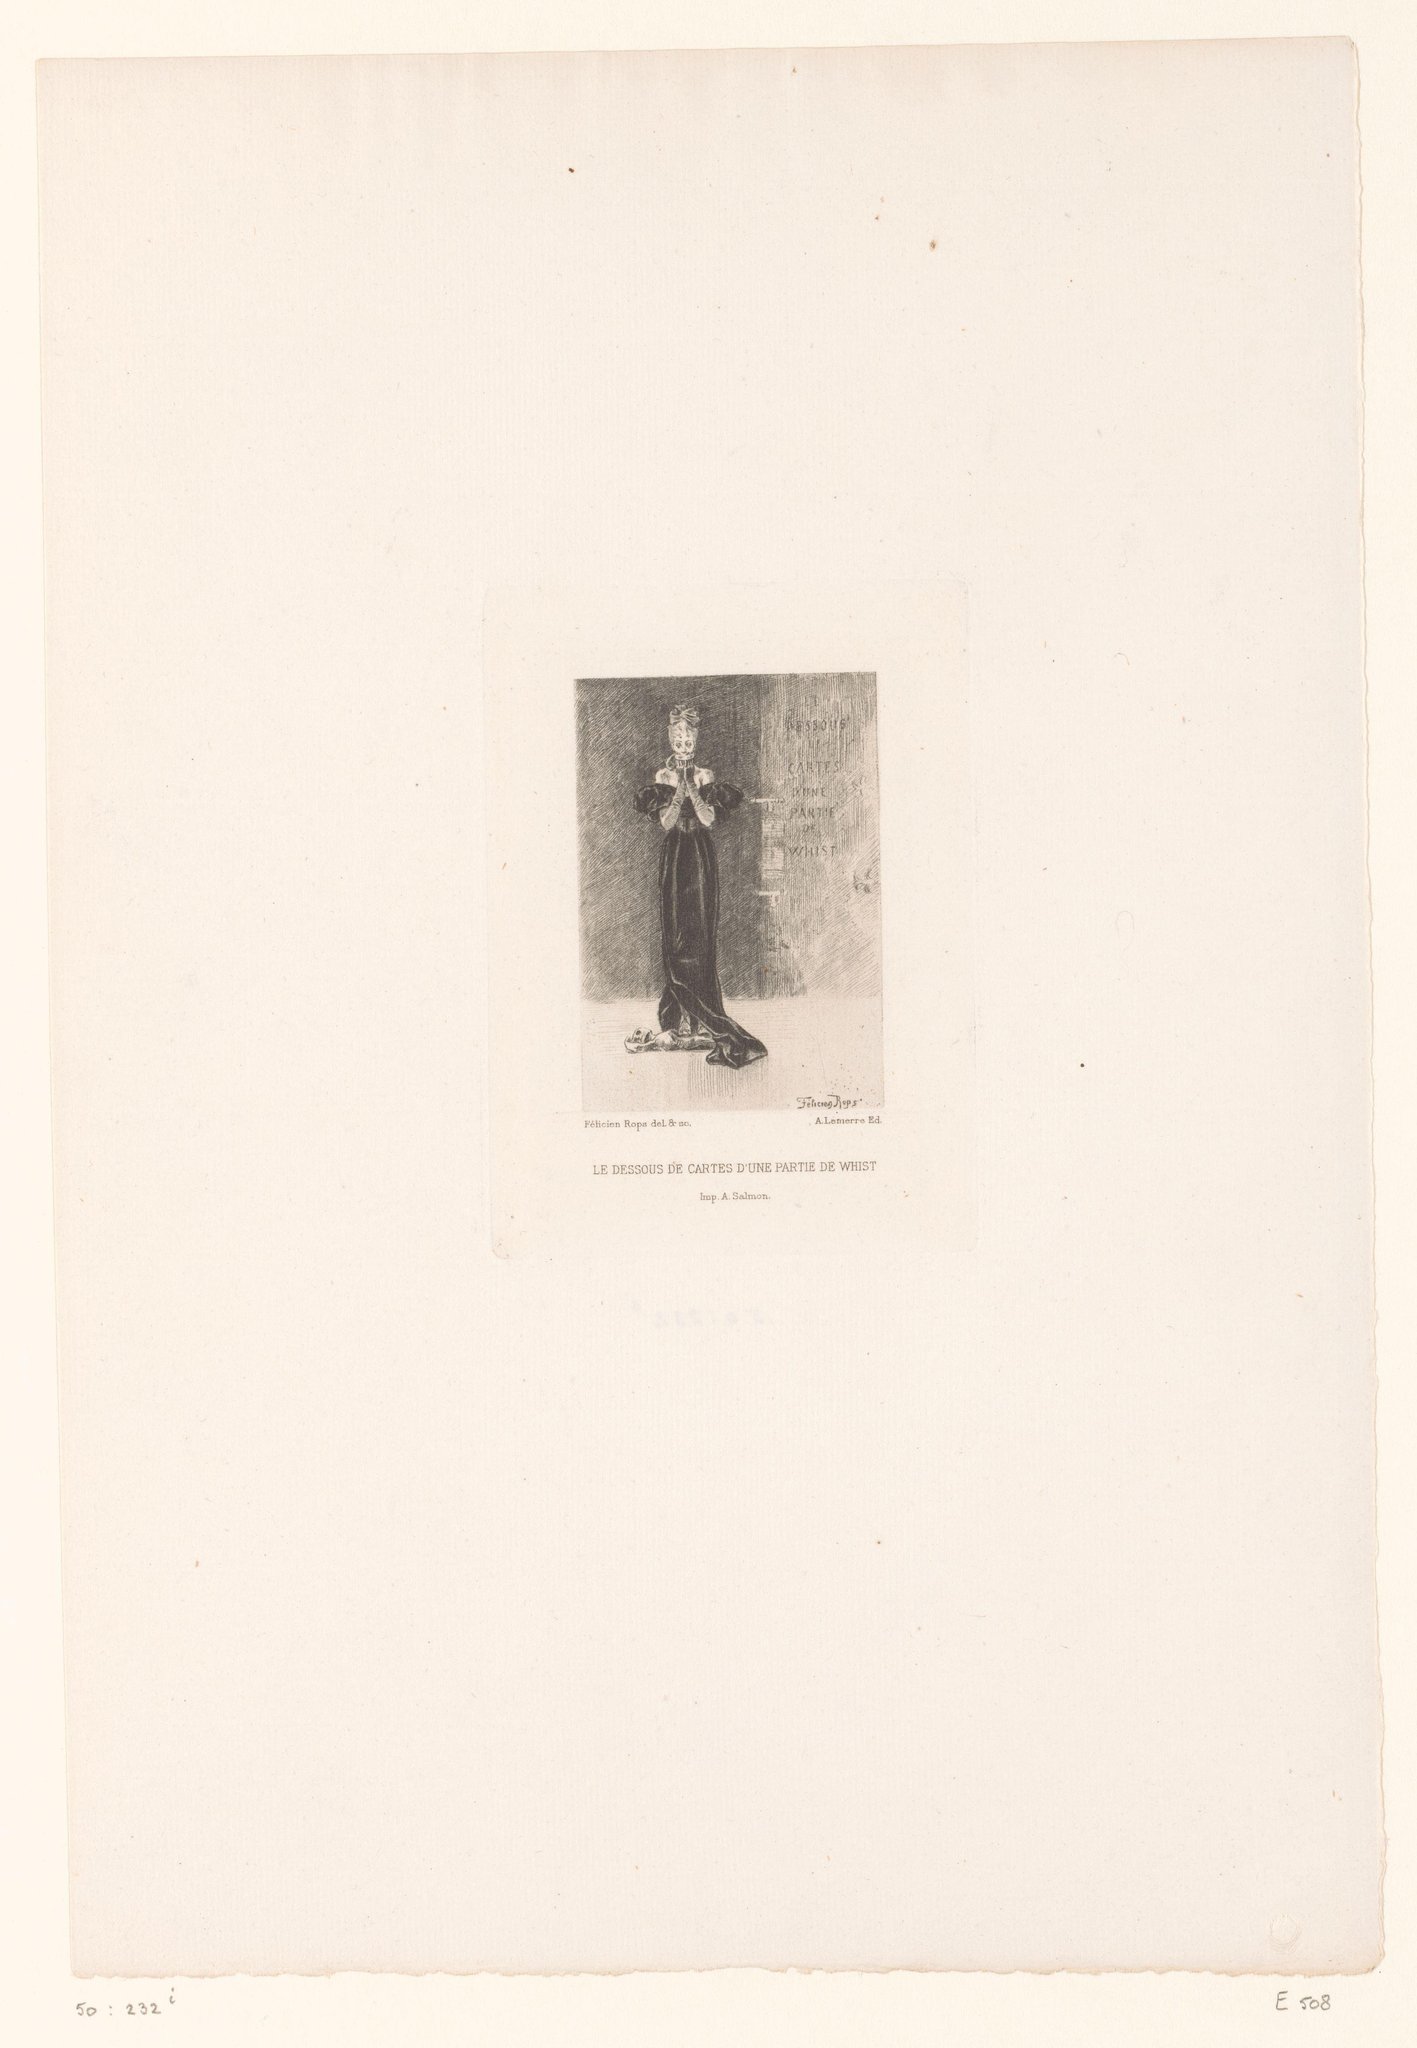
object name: photomechanical print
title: Les diaboliques, petites planches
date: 1886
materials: paper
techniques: drypoint, etching, photoaquatint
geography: paris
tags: the corpse, dress, gown